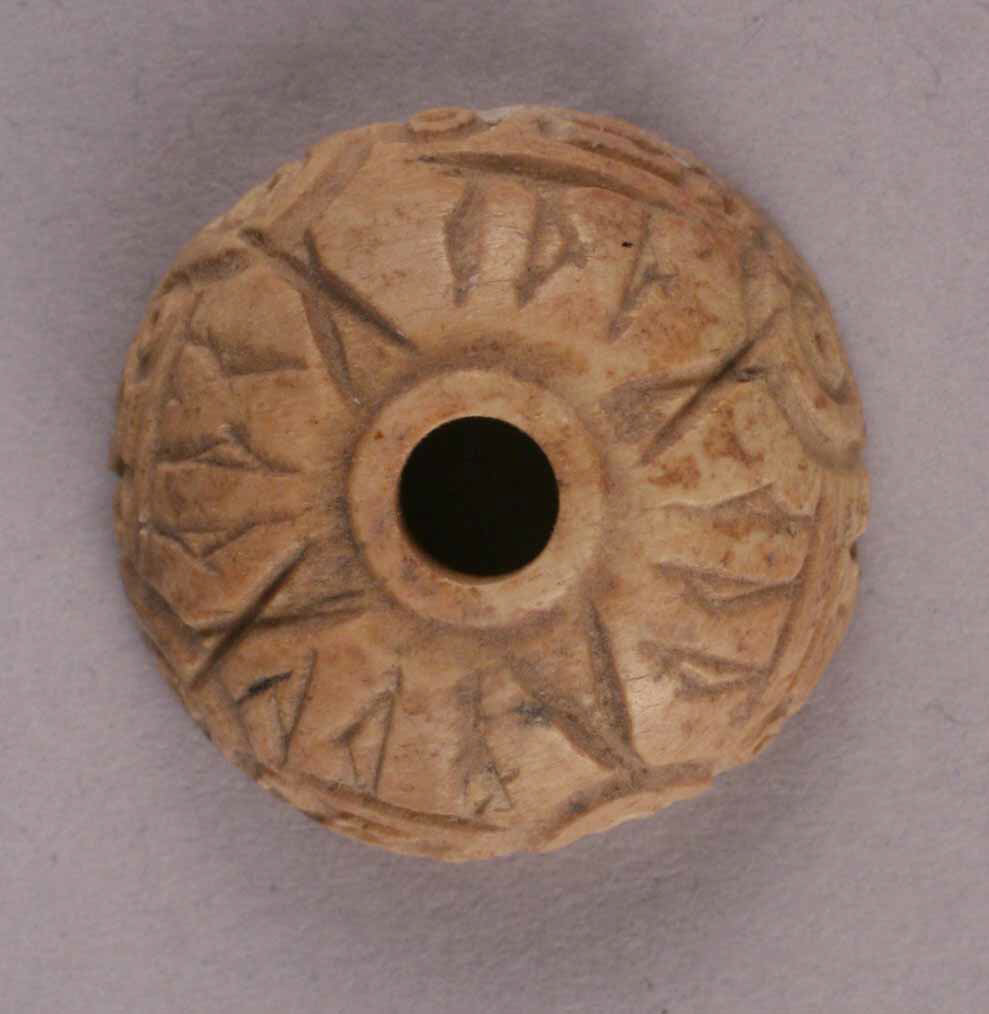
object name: spindle whorl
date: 801-1000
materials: bone, paint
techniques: incising, inlay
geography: iran